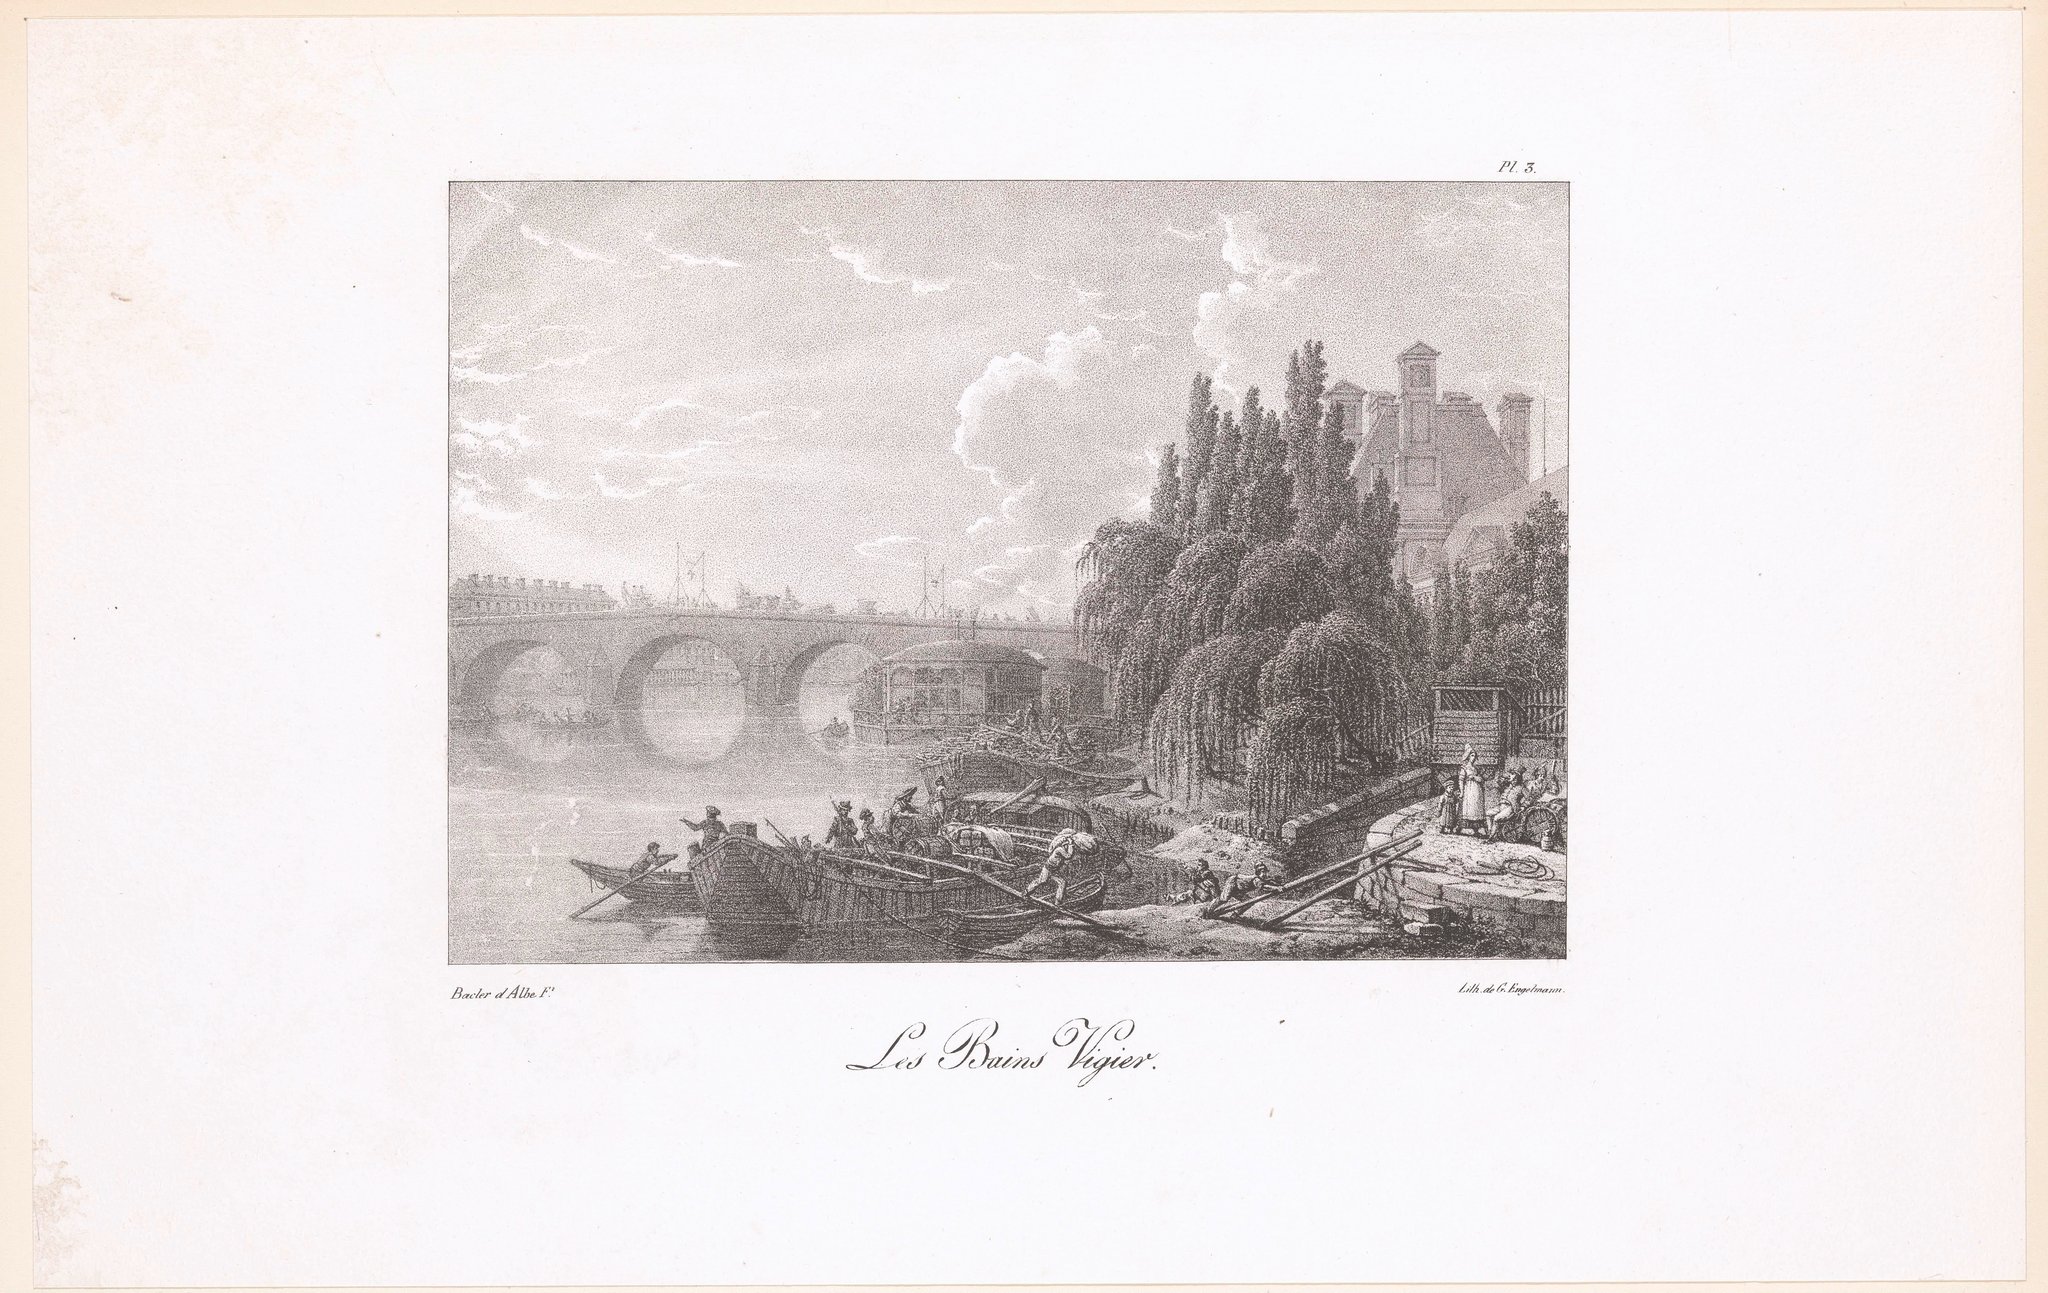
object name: print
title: Zicht op de Bains Vigier aan de oever van de Seine in Parijs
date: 1822-1824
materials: paper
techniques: lithograph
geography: paris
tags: river bank, public baths, rowing-boat, canoe, etc.